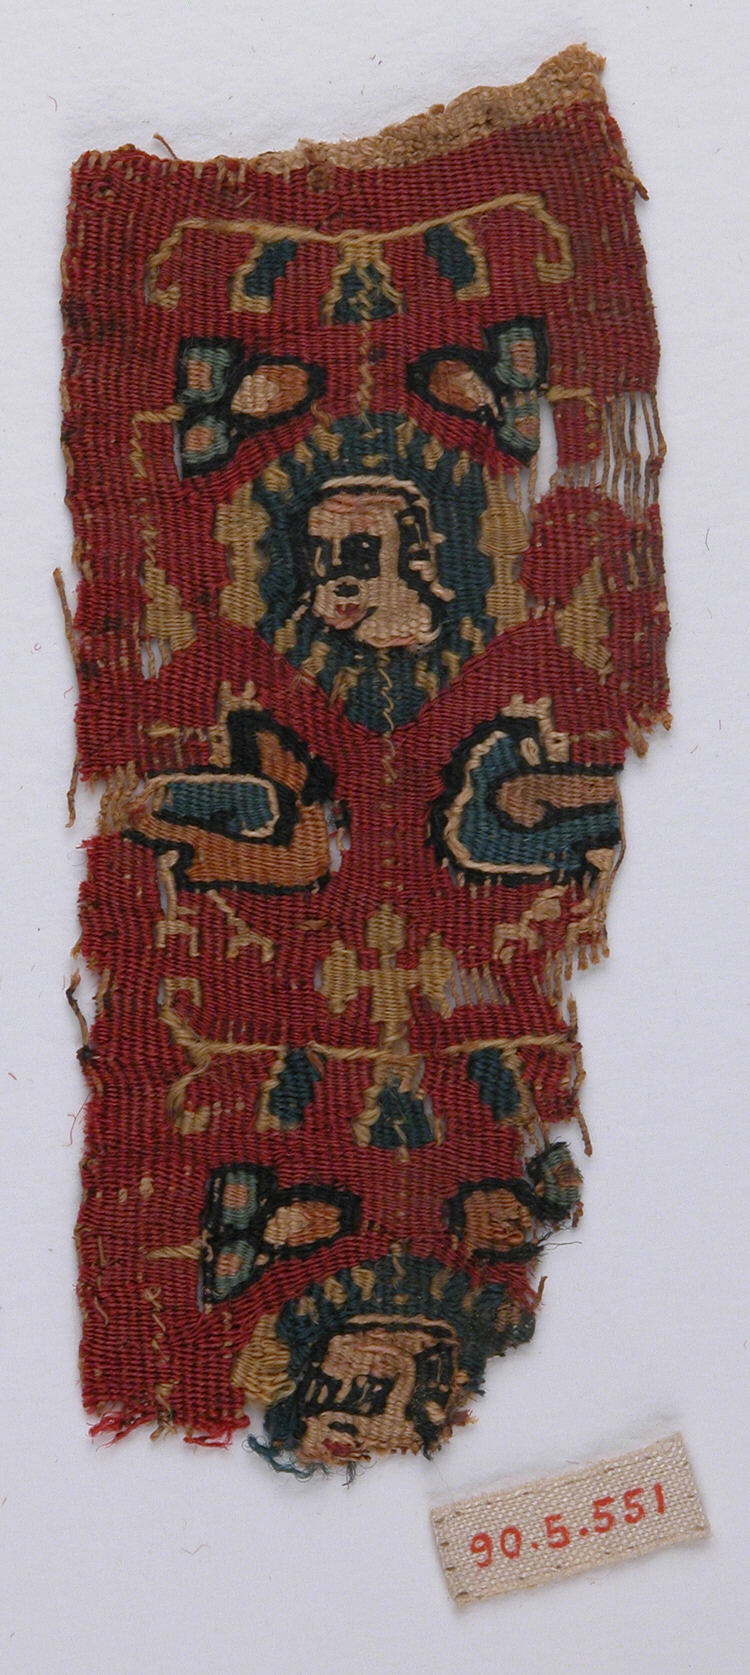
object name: textile fragment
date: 501-700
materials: linen, wool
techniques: weave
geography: egypt